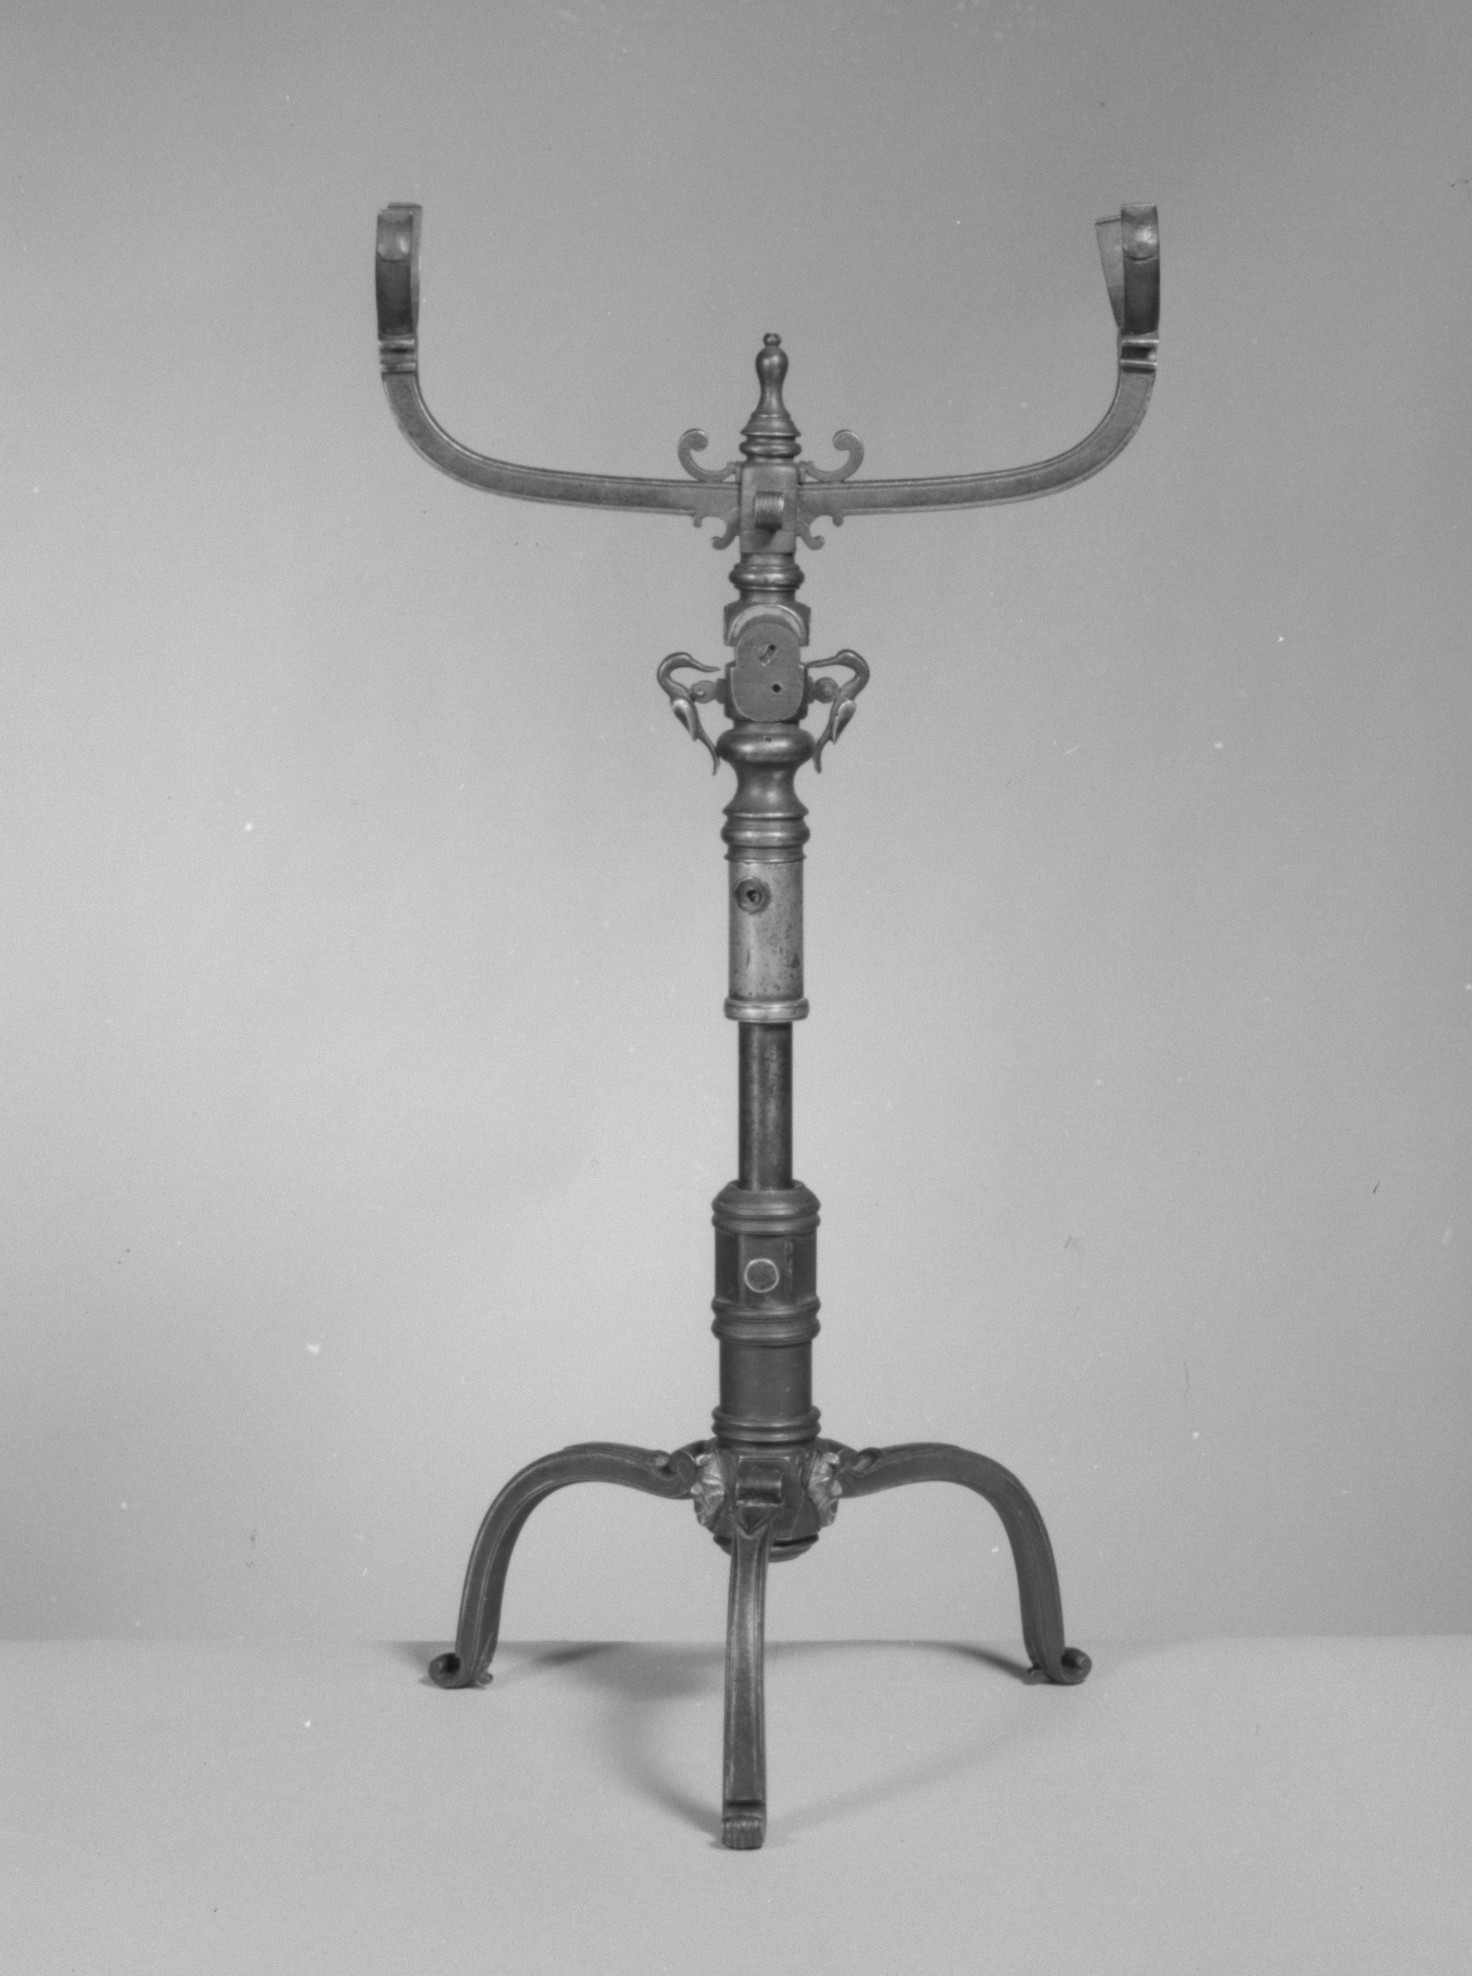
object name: telescope stand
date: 1601-1700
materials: brass, iron